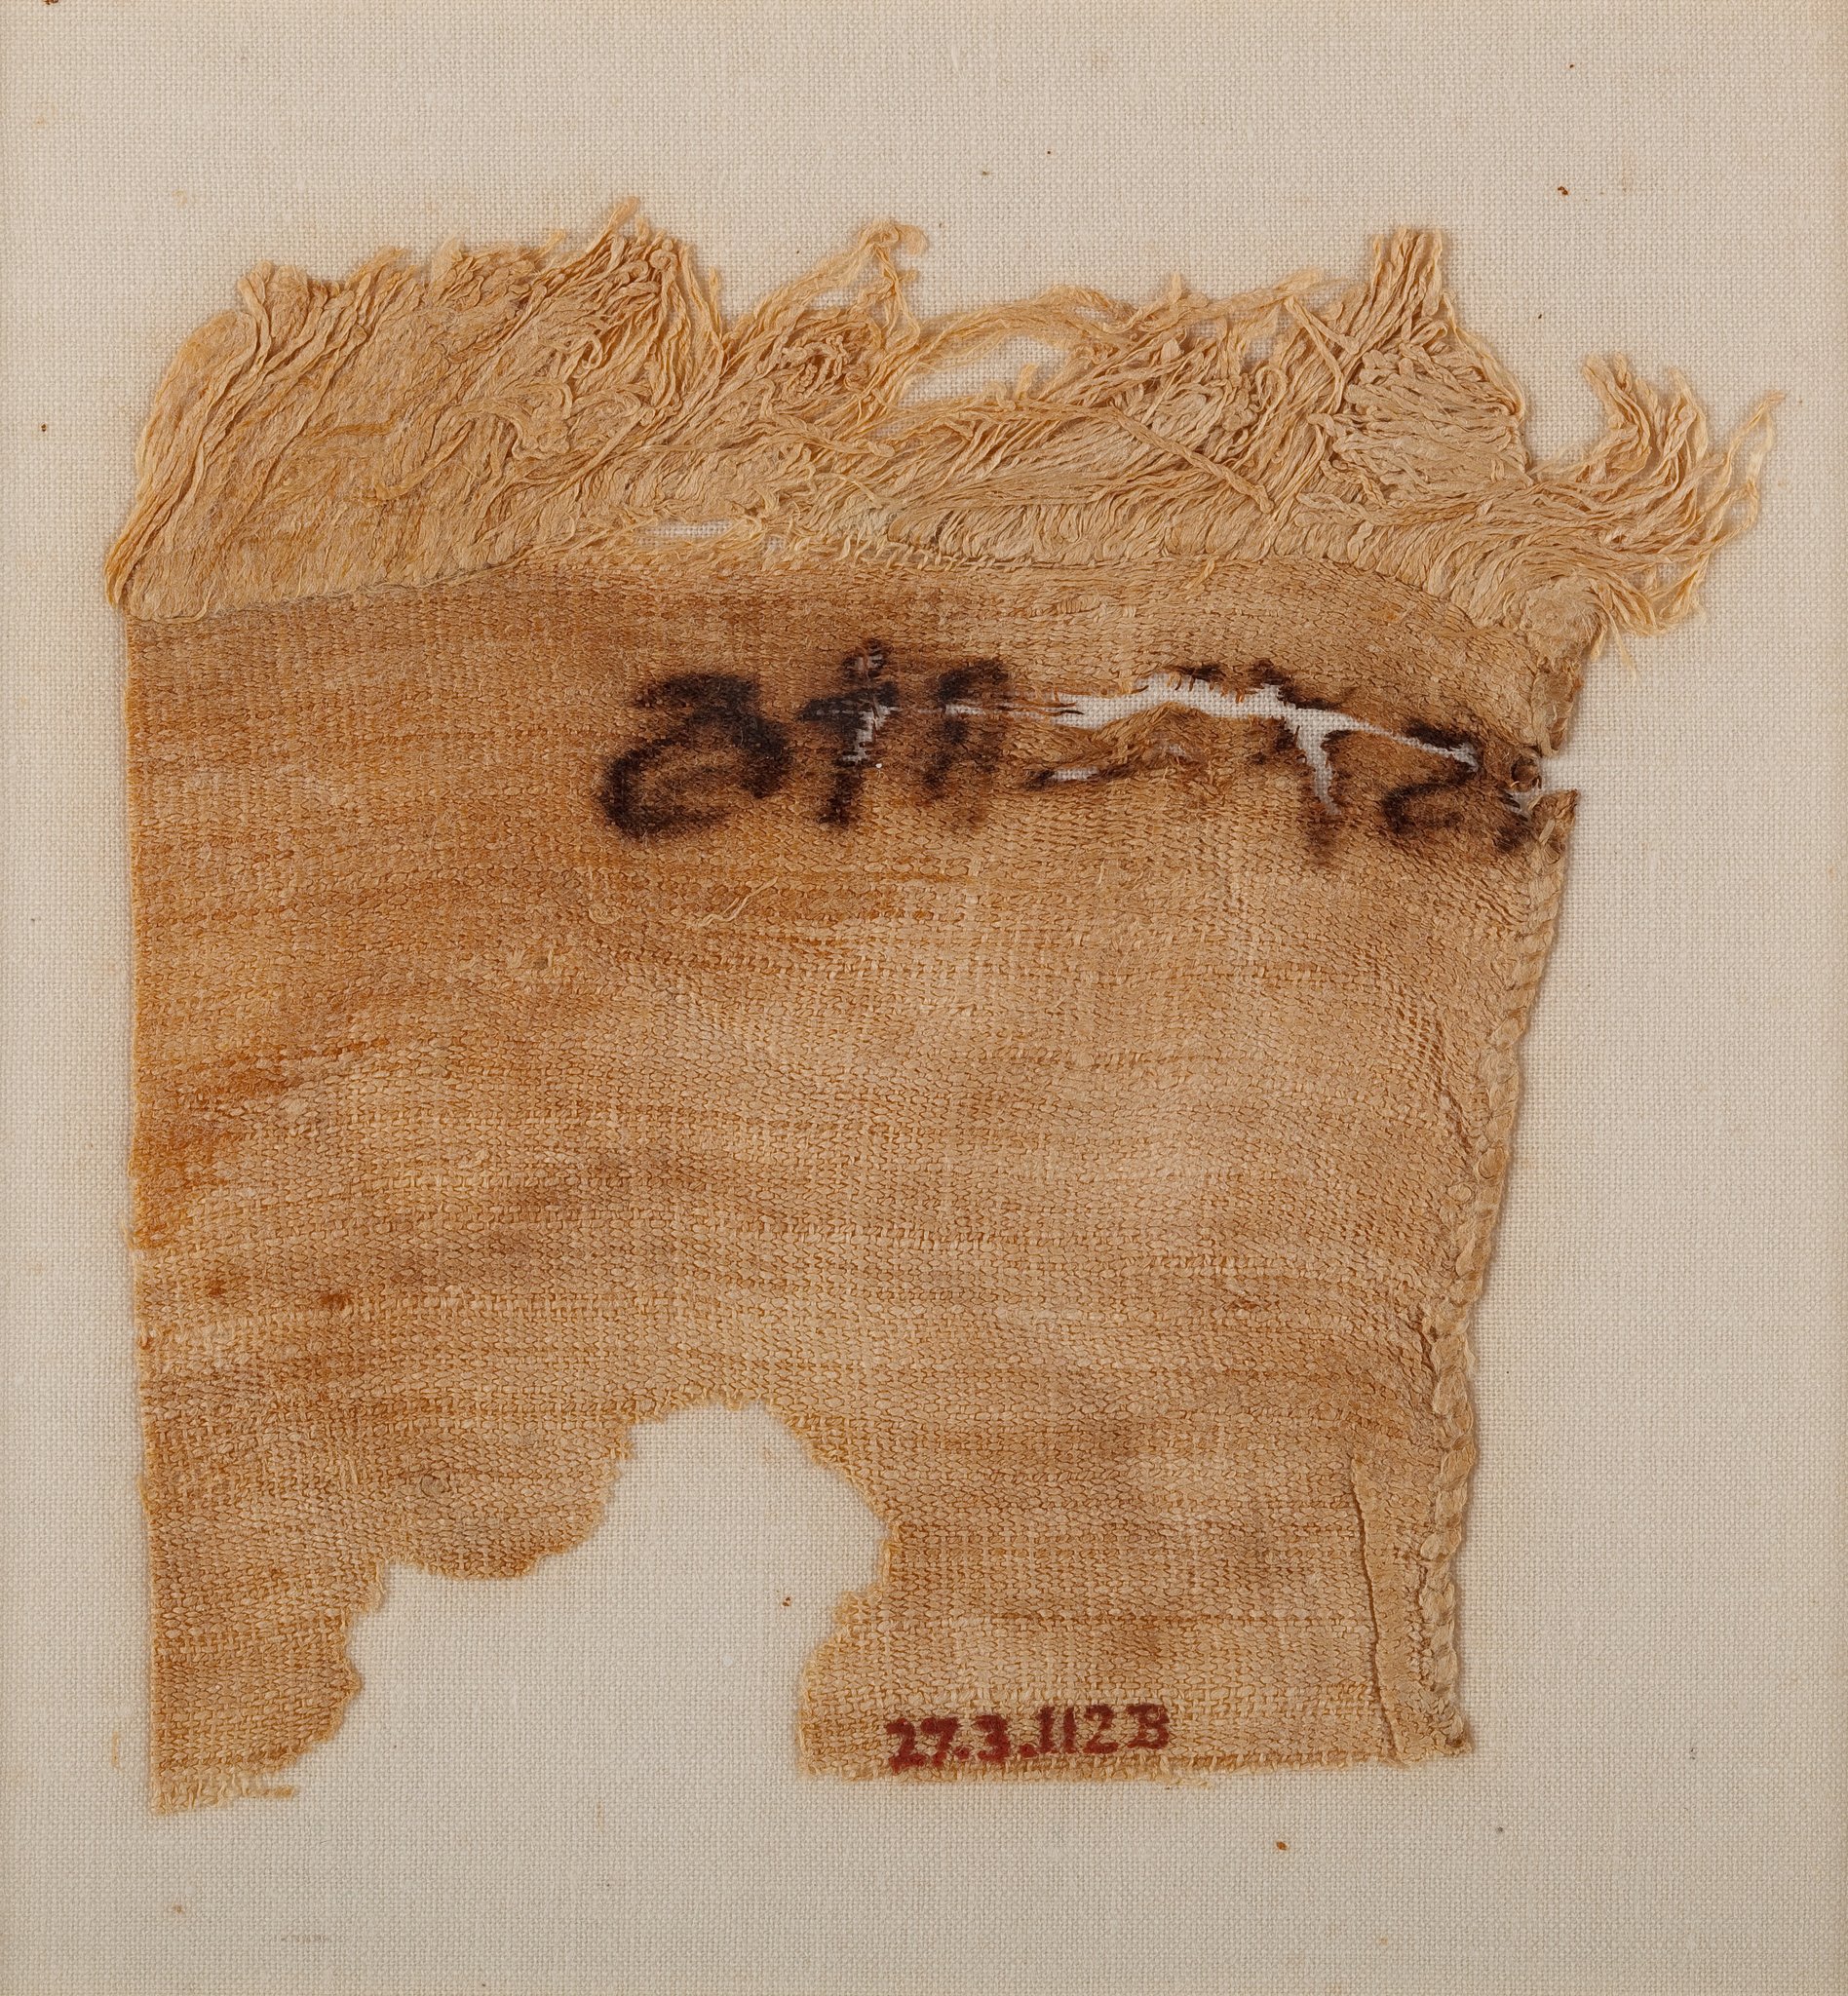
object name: linen mark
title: Linen mark (Type XIV)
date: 1961-1917 BCE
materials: linen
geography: egypt